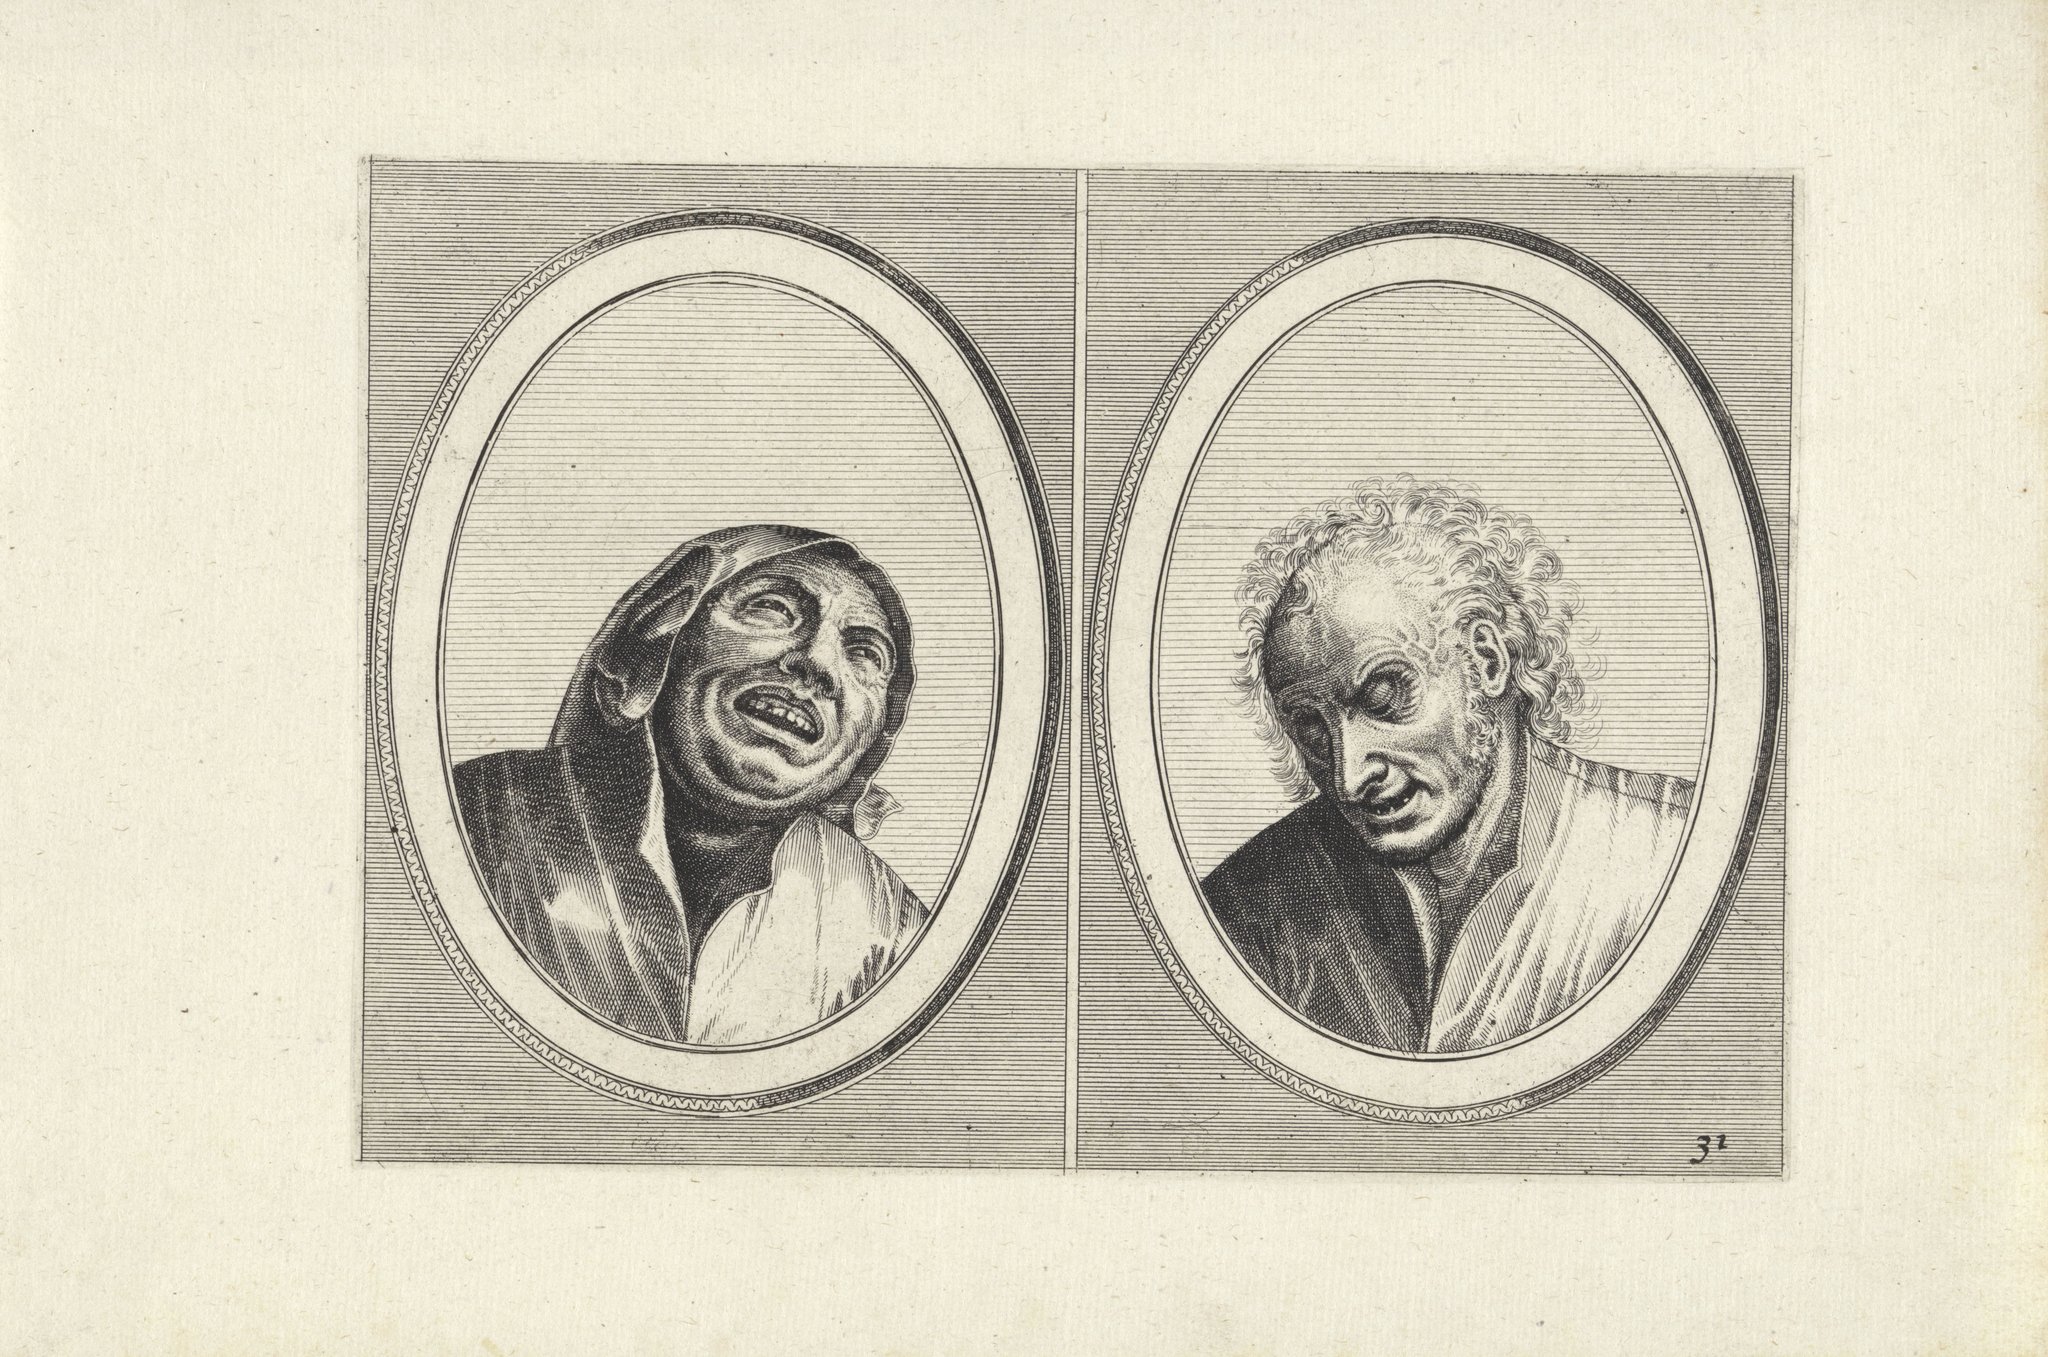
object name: print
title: Foockel Lach-een-reys en Lazarus Sonder-Zeer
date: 1612-1652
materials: paper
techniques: engraving, etching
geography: amsterdam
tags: head-gear, farmers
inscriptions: collector's mark: Lugt 2228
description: Prent uit een serie van 36 prenten met koppen van boeren en boerinnen.